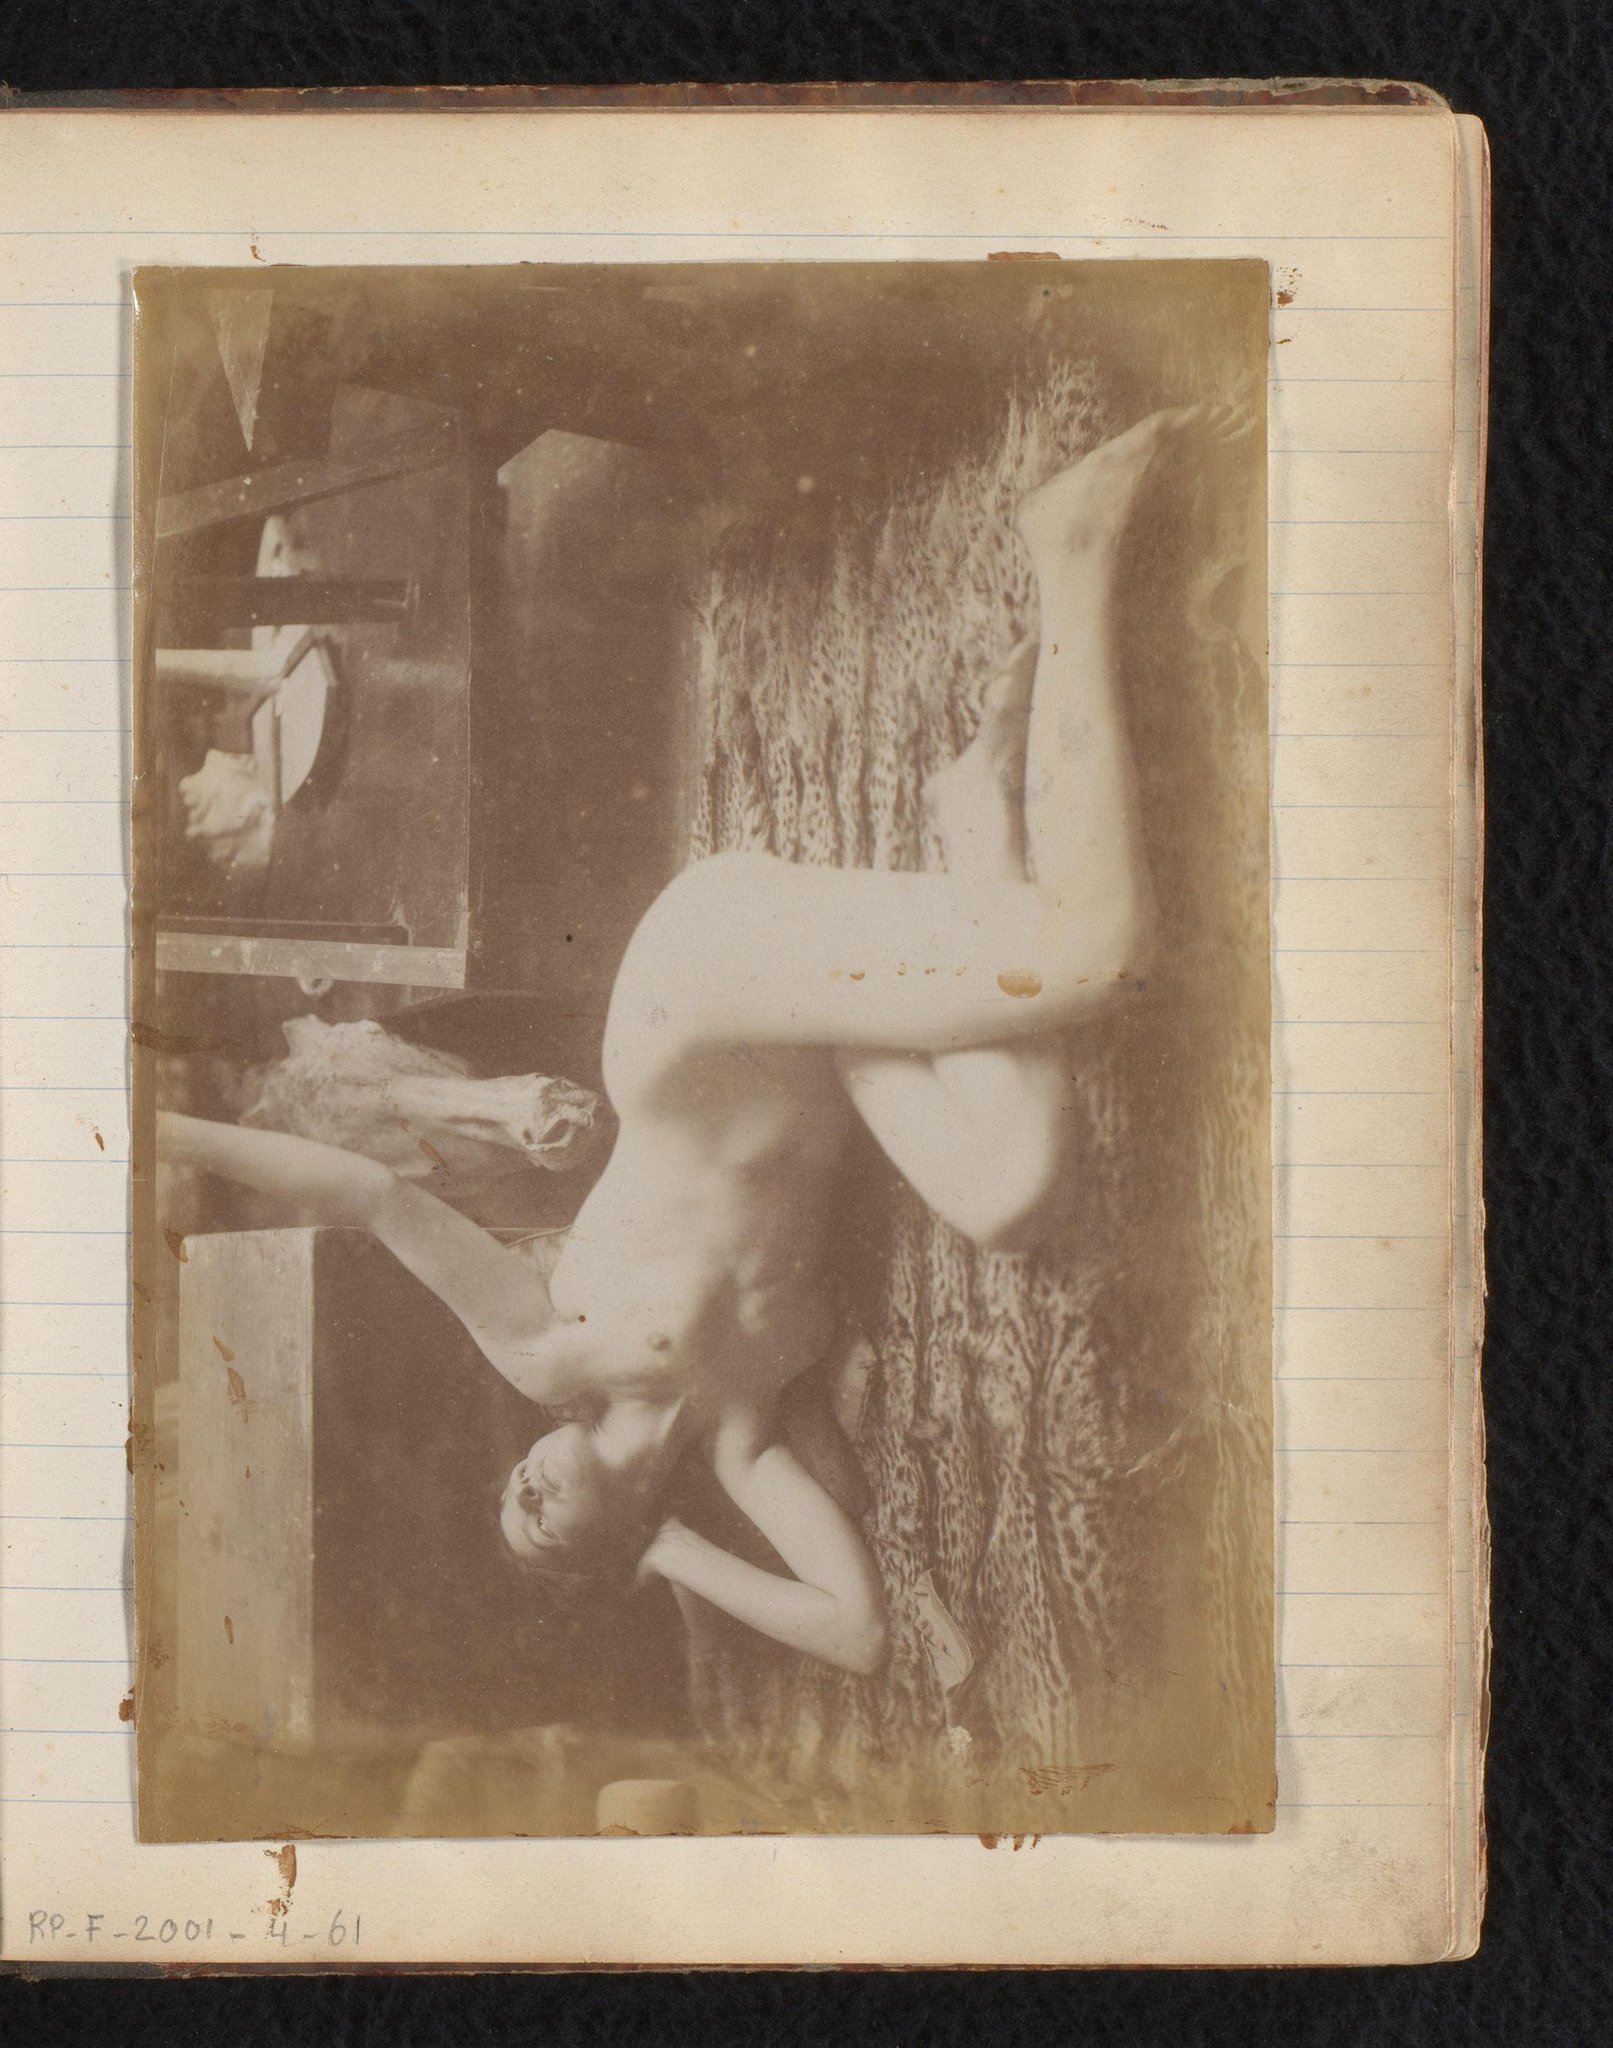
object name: photograph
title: Studie van een vrouwelijk naaktmodel, liggend op een tijgervel, in het atelier van Jacques de Lalaing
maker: jacques lalaing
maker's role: painter, sculptor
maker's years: 1858-1917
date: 1883-1914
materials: photographic support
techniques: albumen print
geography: brussels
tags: adult woman, the (nude) human figure; 'corpo humano' (ripa) (+ lying), artist (in general) working from nude model